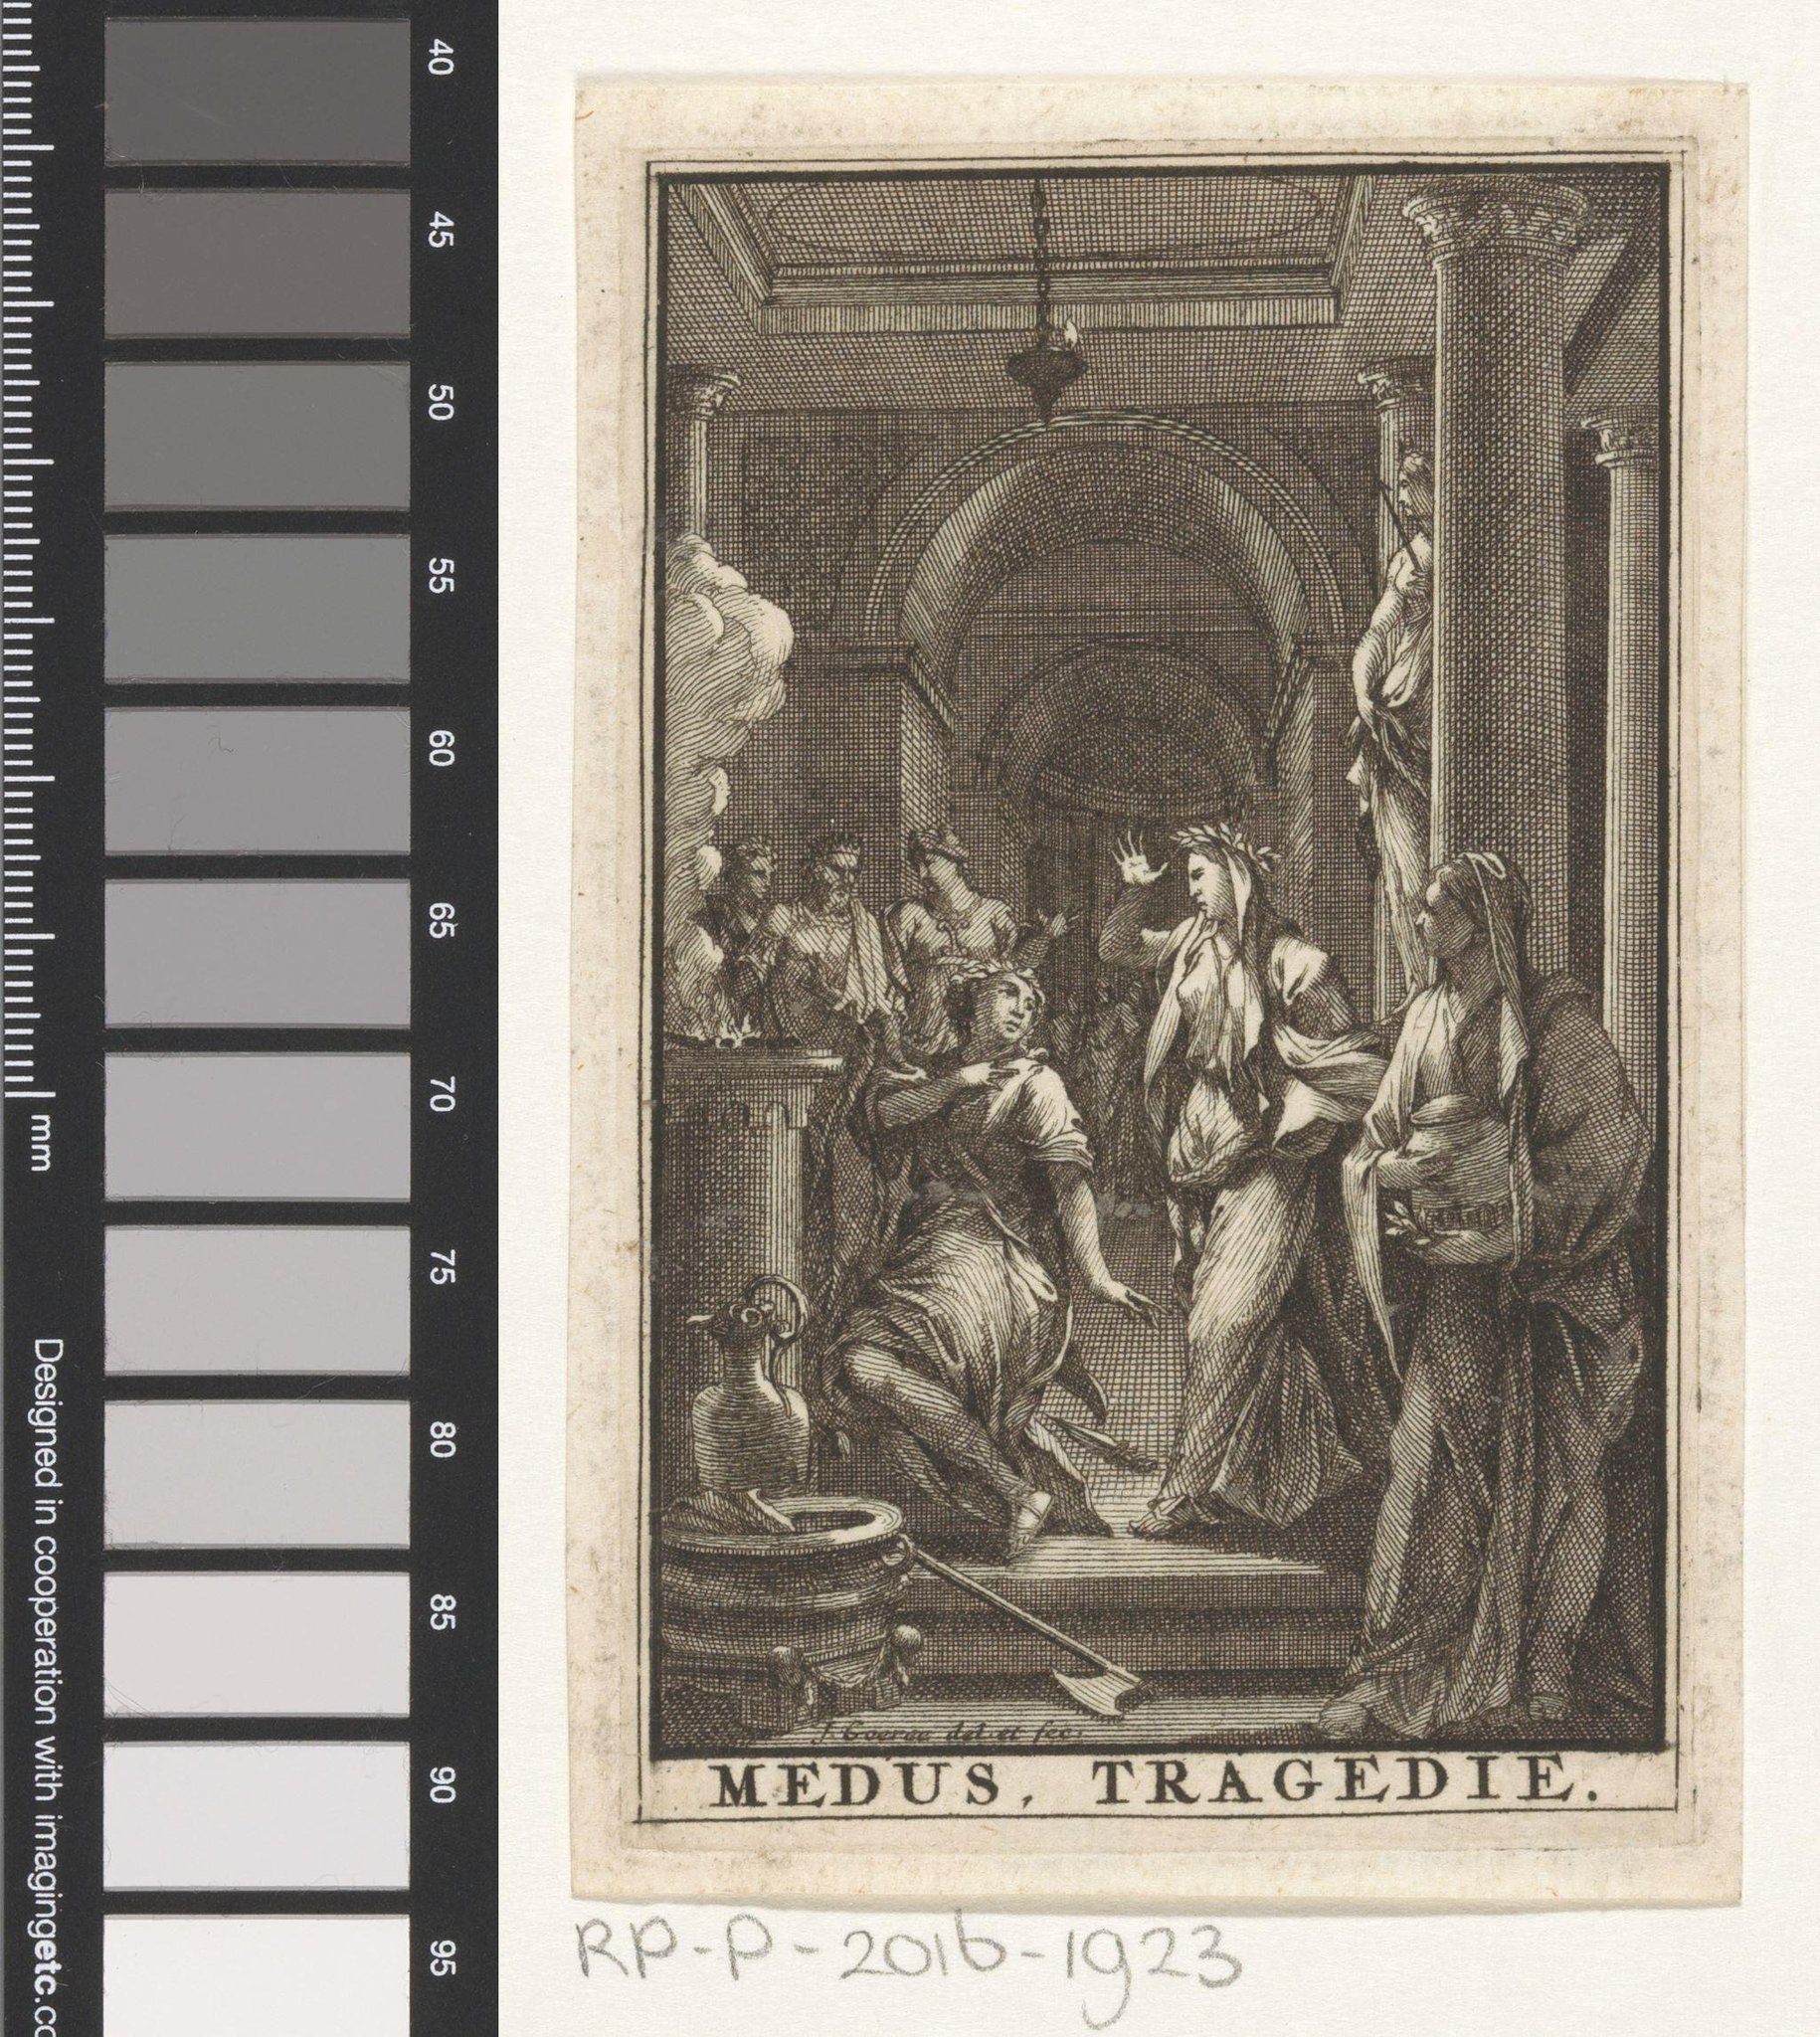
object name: titelblad, titelpagina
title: Titelpagina voor: François Michel Chrétien Deschamps, Medus, tragedie, 1739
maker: jan goeree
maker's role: draughtsman, print maker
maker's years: 1670-1731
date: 1739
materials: paper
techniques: engraving, etching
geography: paris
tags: (story of) diana (artemis), medusa (one of the gorgons), temple, shrine ~ roman religion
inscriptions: collector's mark: Lugt 2228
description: Titelpagina voor: Deschamps, François Michel Chrétien. Medus, tragedie. Parijs: Prault, fils, 1739. Prent afkomstig uit een plakalbum met titelprenten, ornamenten etc. op blauw papier in 1983 uit elkaar gehaald. Volgens een notitie op verso zat de prent op p. 115 van dit album.